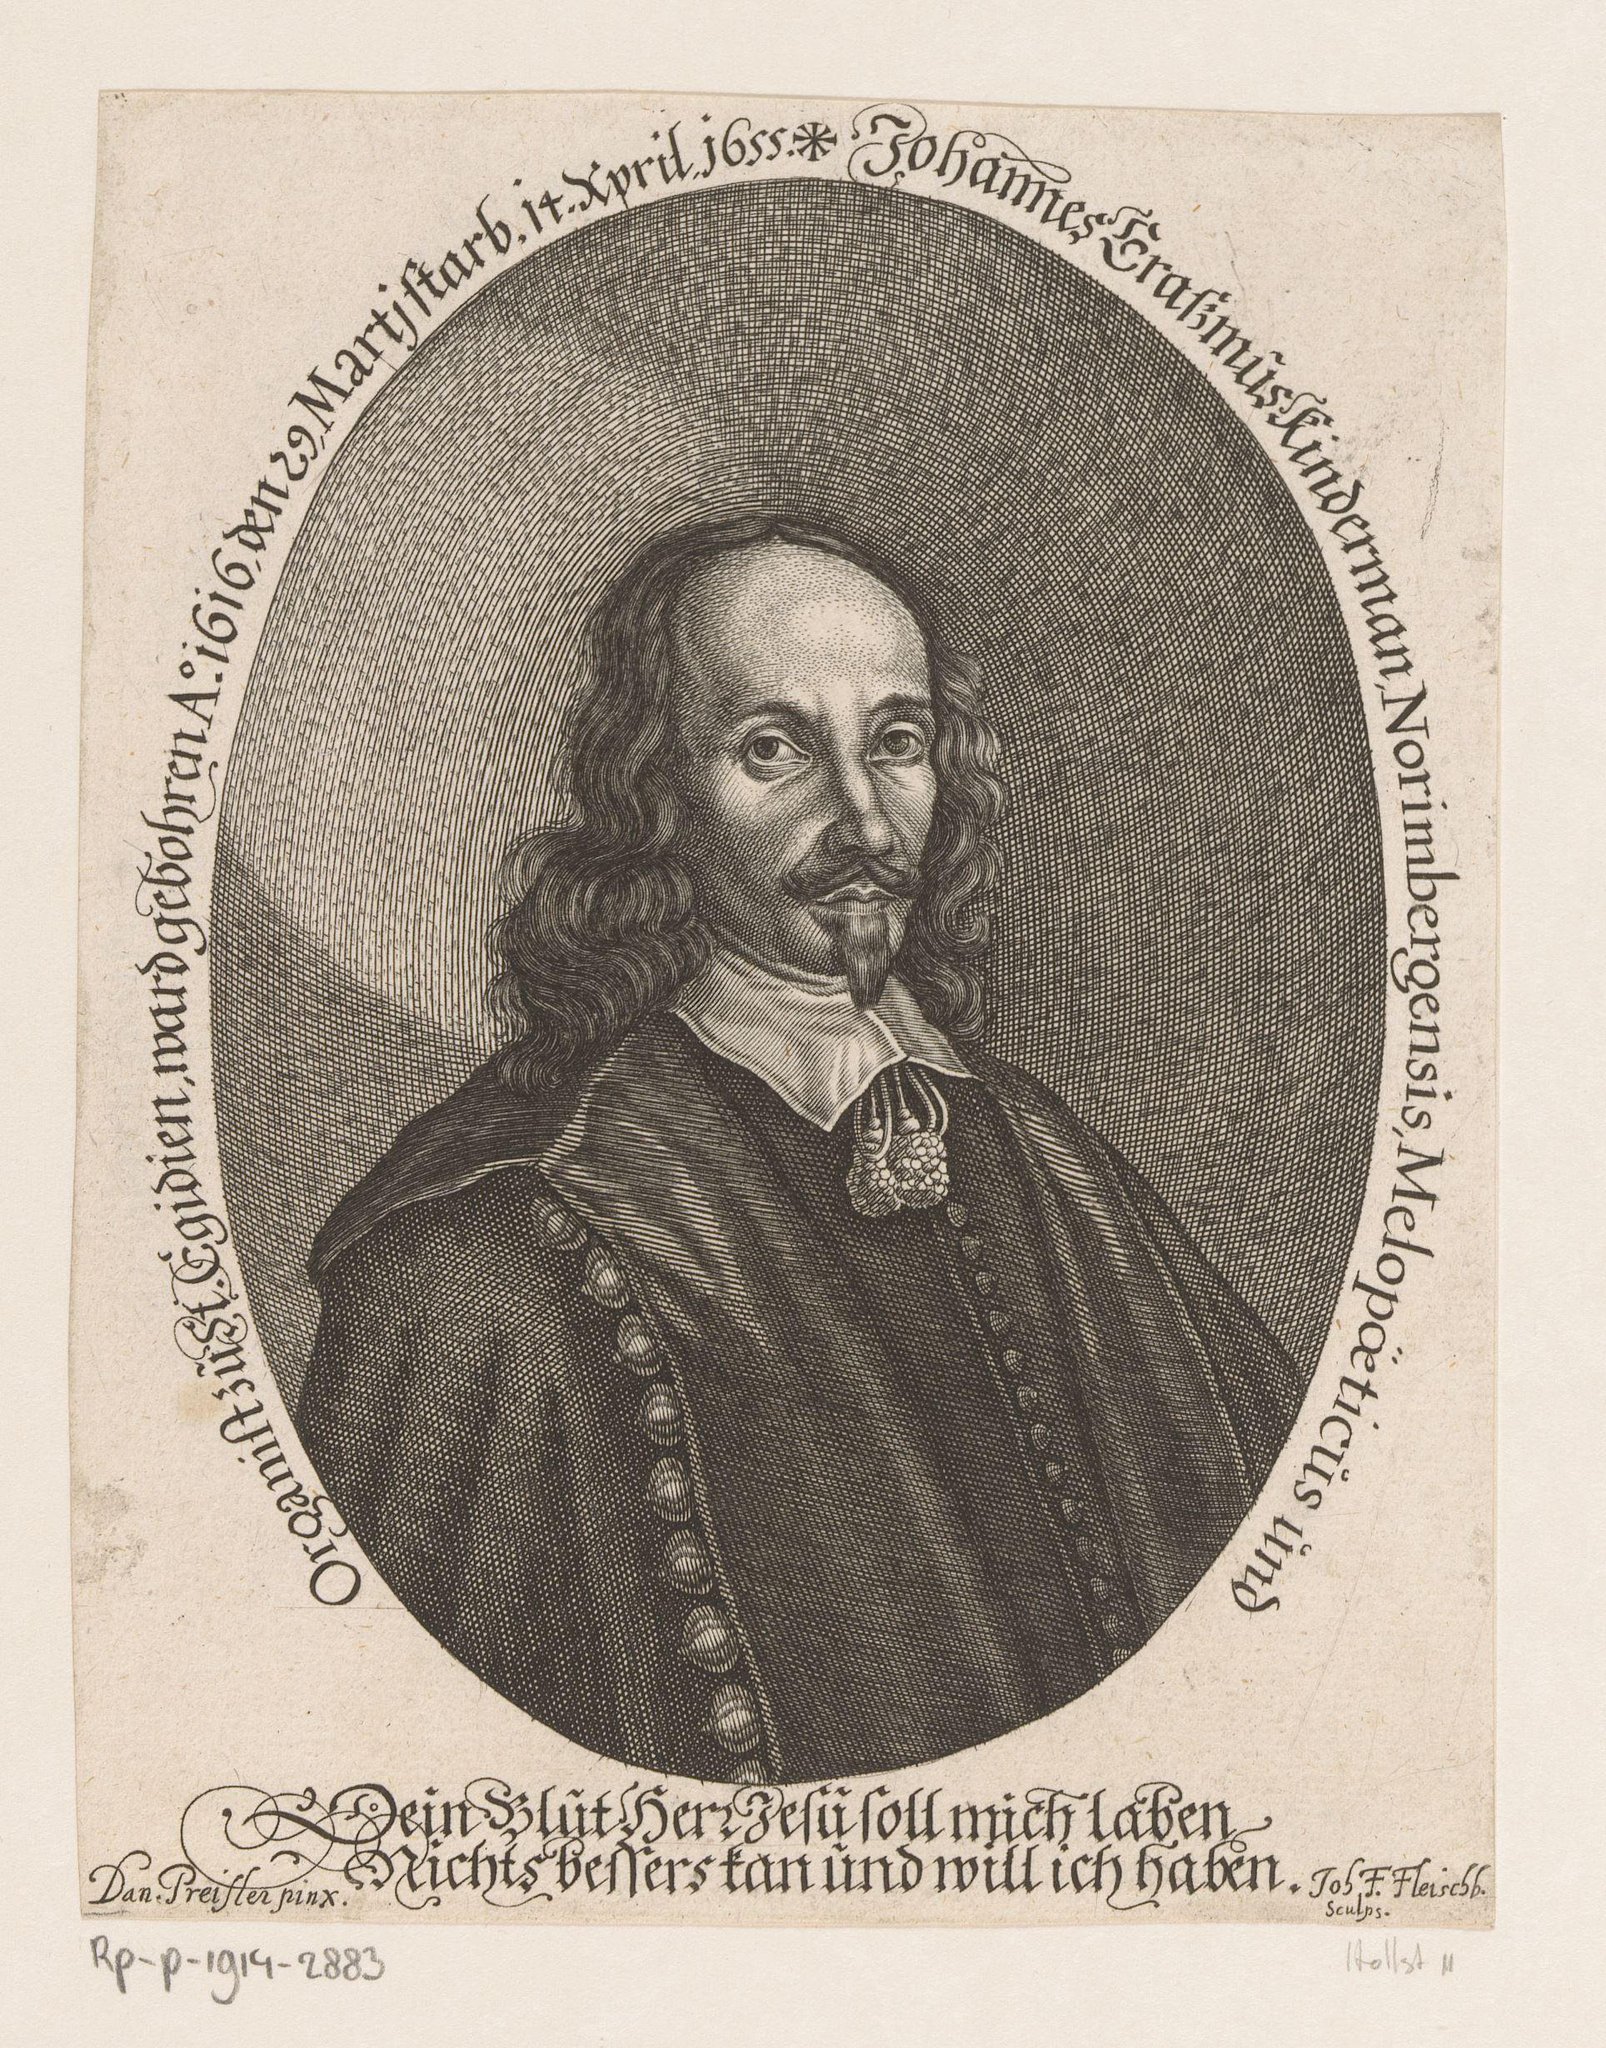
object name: print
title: Portret van Johann Erasmus Kindermann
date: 1655-1665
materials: paper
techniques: engraving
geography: nuremberg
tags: historical persons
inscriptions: collector's mark: Lugt 2228